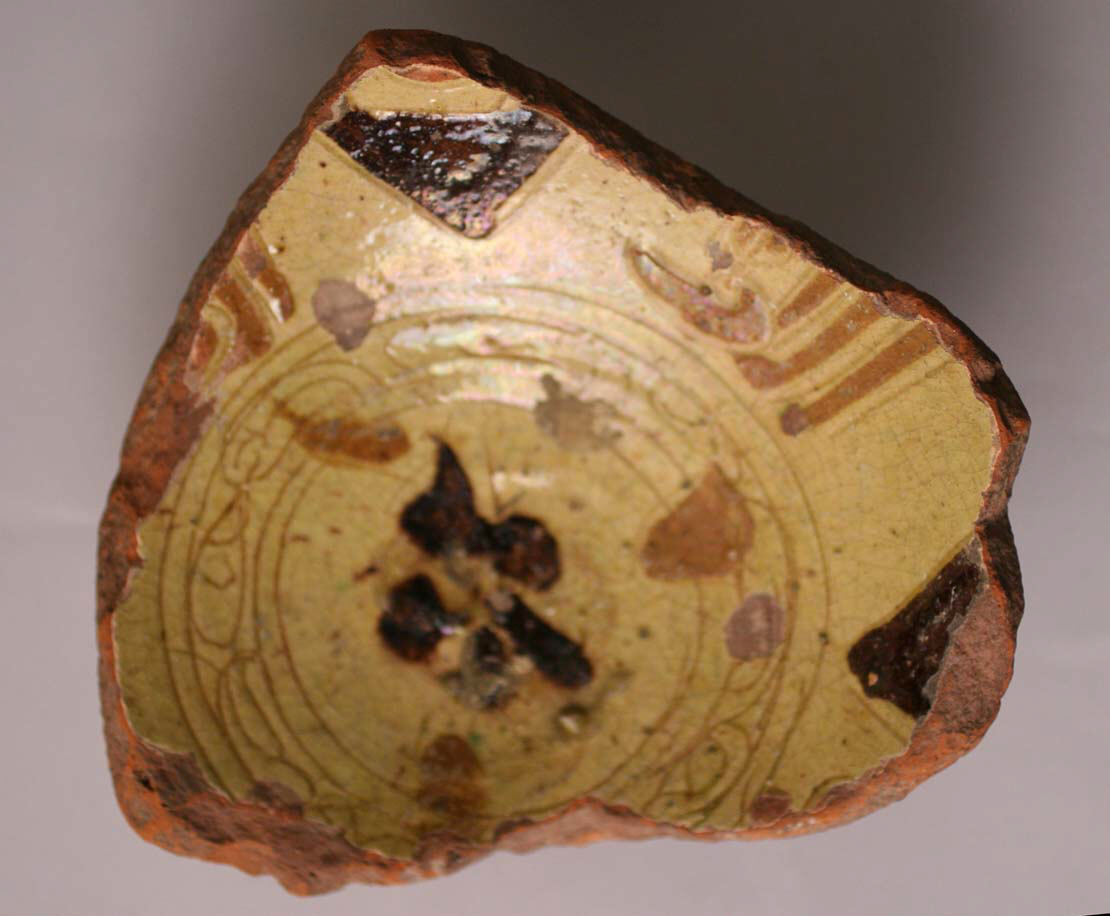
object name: ceramic fragment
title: Fragment of a Bowl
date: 1301-1500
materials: earthenware, glaze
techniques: coloring, incising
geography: egypt